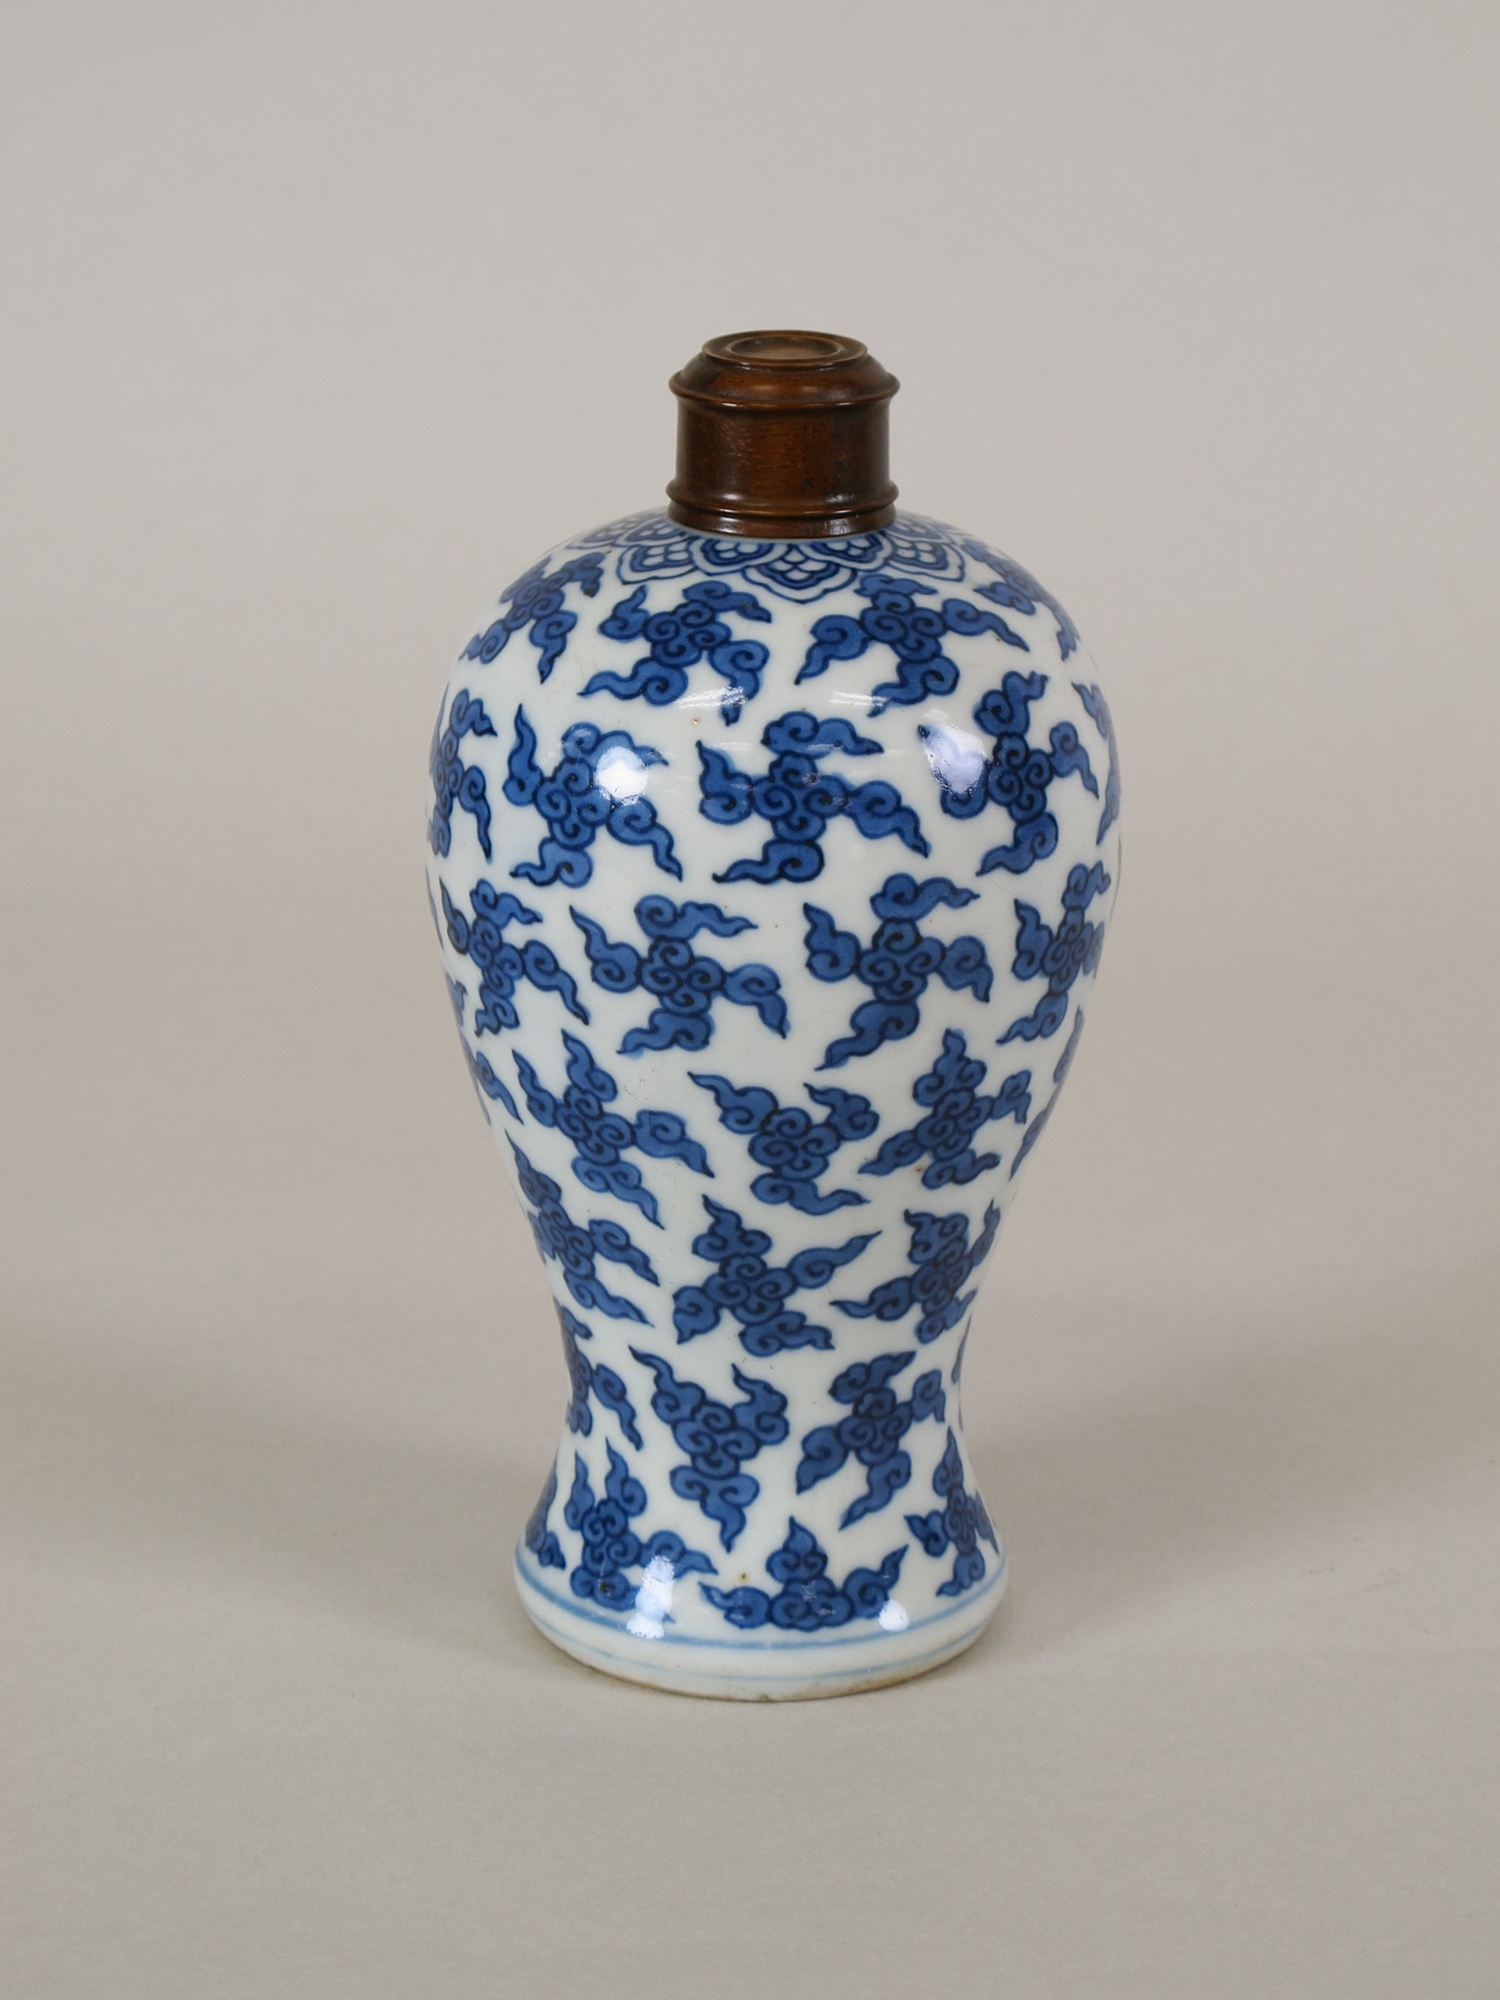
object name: vase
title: Vase with clouds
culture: chinese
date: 1501-1600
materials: porcelain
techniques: painting, underglaze